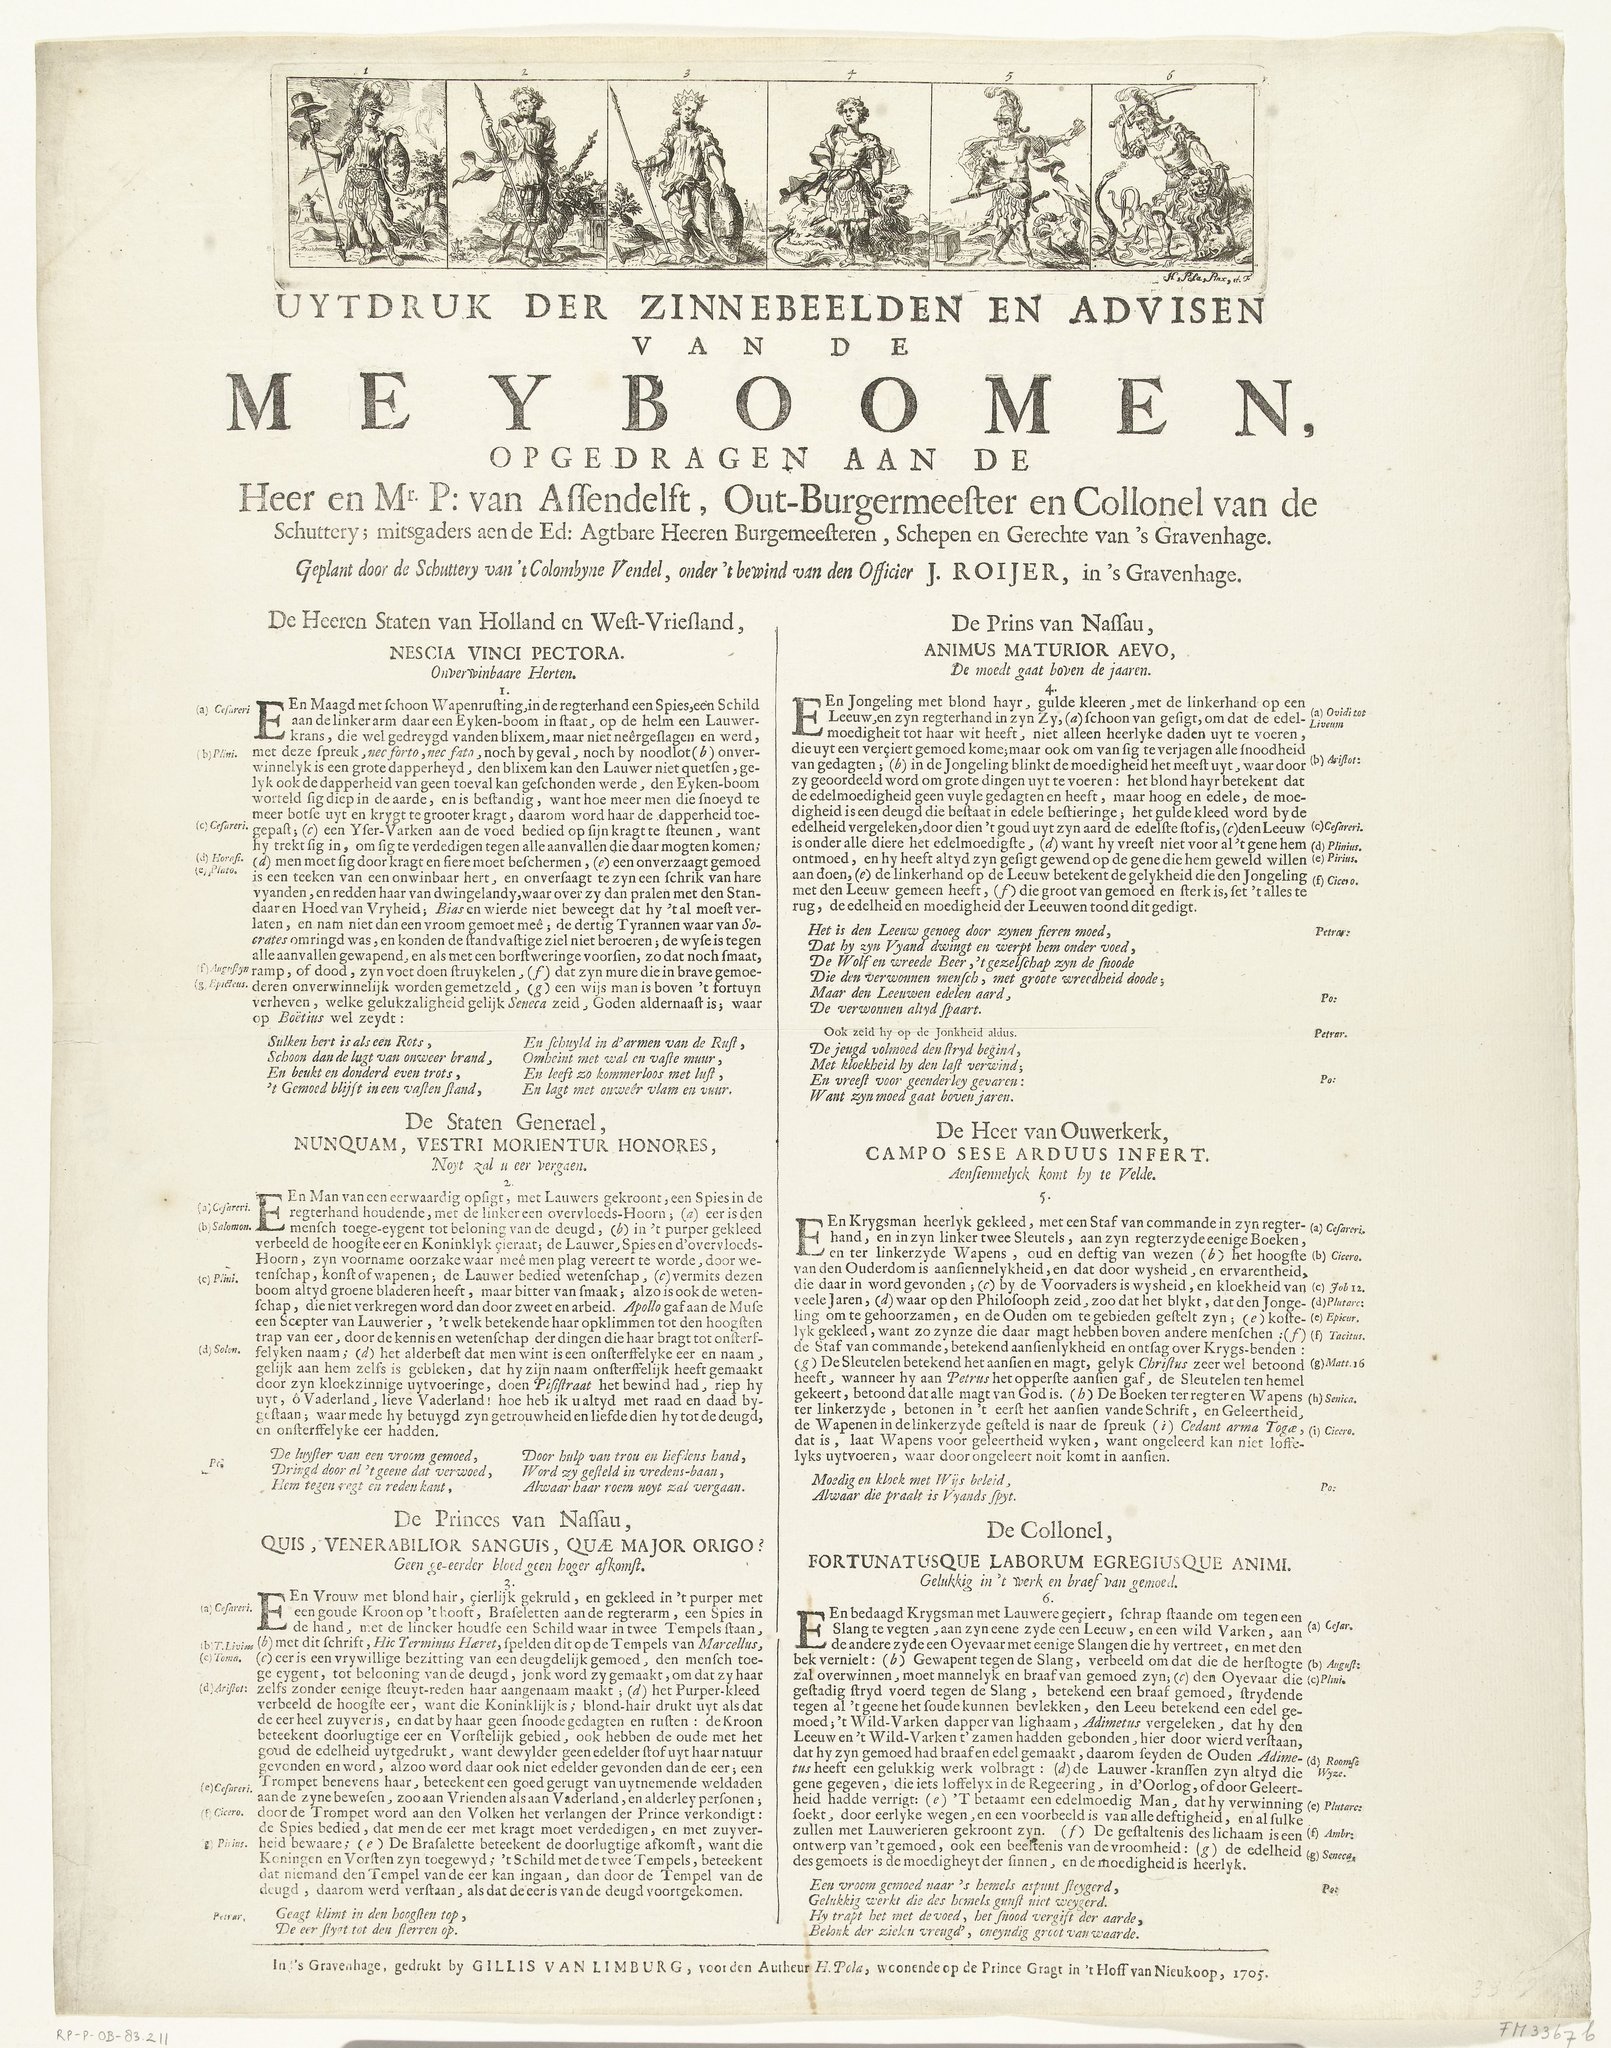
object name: print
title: Uytdruk der Zinnebeelden en Advisen van de Meyboomen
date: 1705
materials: paper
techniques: etching, letterpress printing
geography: the hague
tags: johan willem friso (prins van oranje-nassau), the hague, mayor, mr. paulus van assendelft, maypole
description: Uitleg van de zes zinnebeelden op de meibomen opgericht door de schutterij van 't Colombyne Vendel van de officier J. Royer te Den Haag, 1705. Bovenaan zes allegorische figuren verwijzende naar de Staten van Holland en West-Friesland, de Staten-Generaal, de prins en prinses van Oranje, de heer van Ouwerkerk en de Colonel P. van Assendelft.